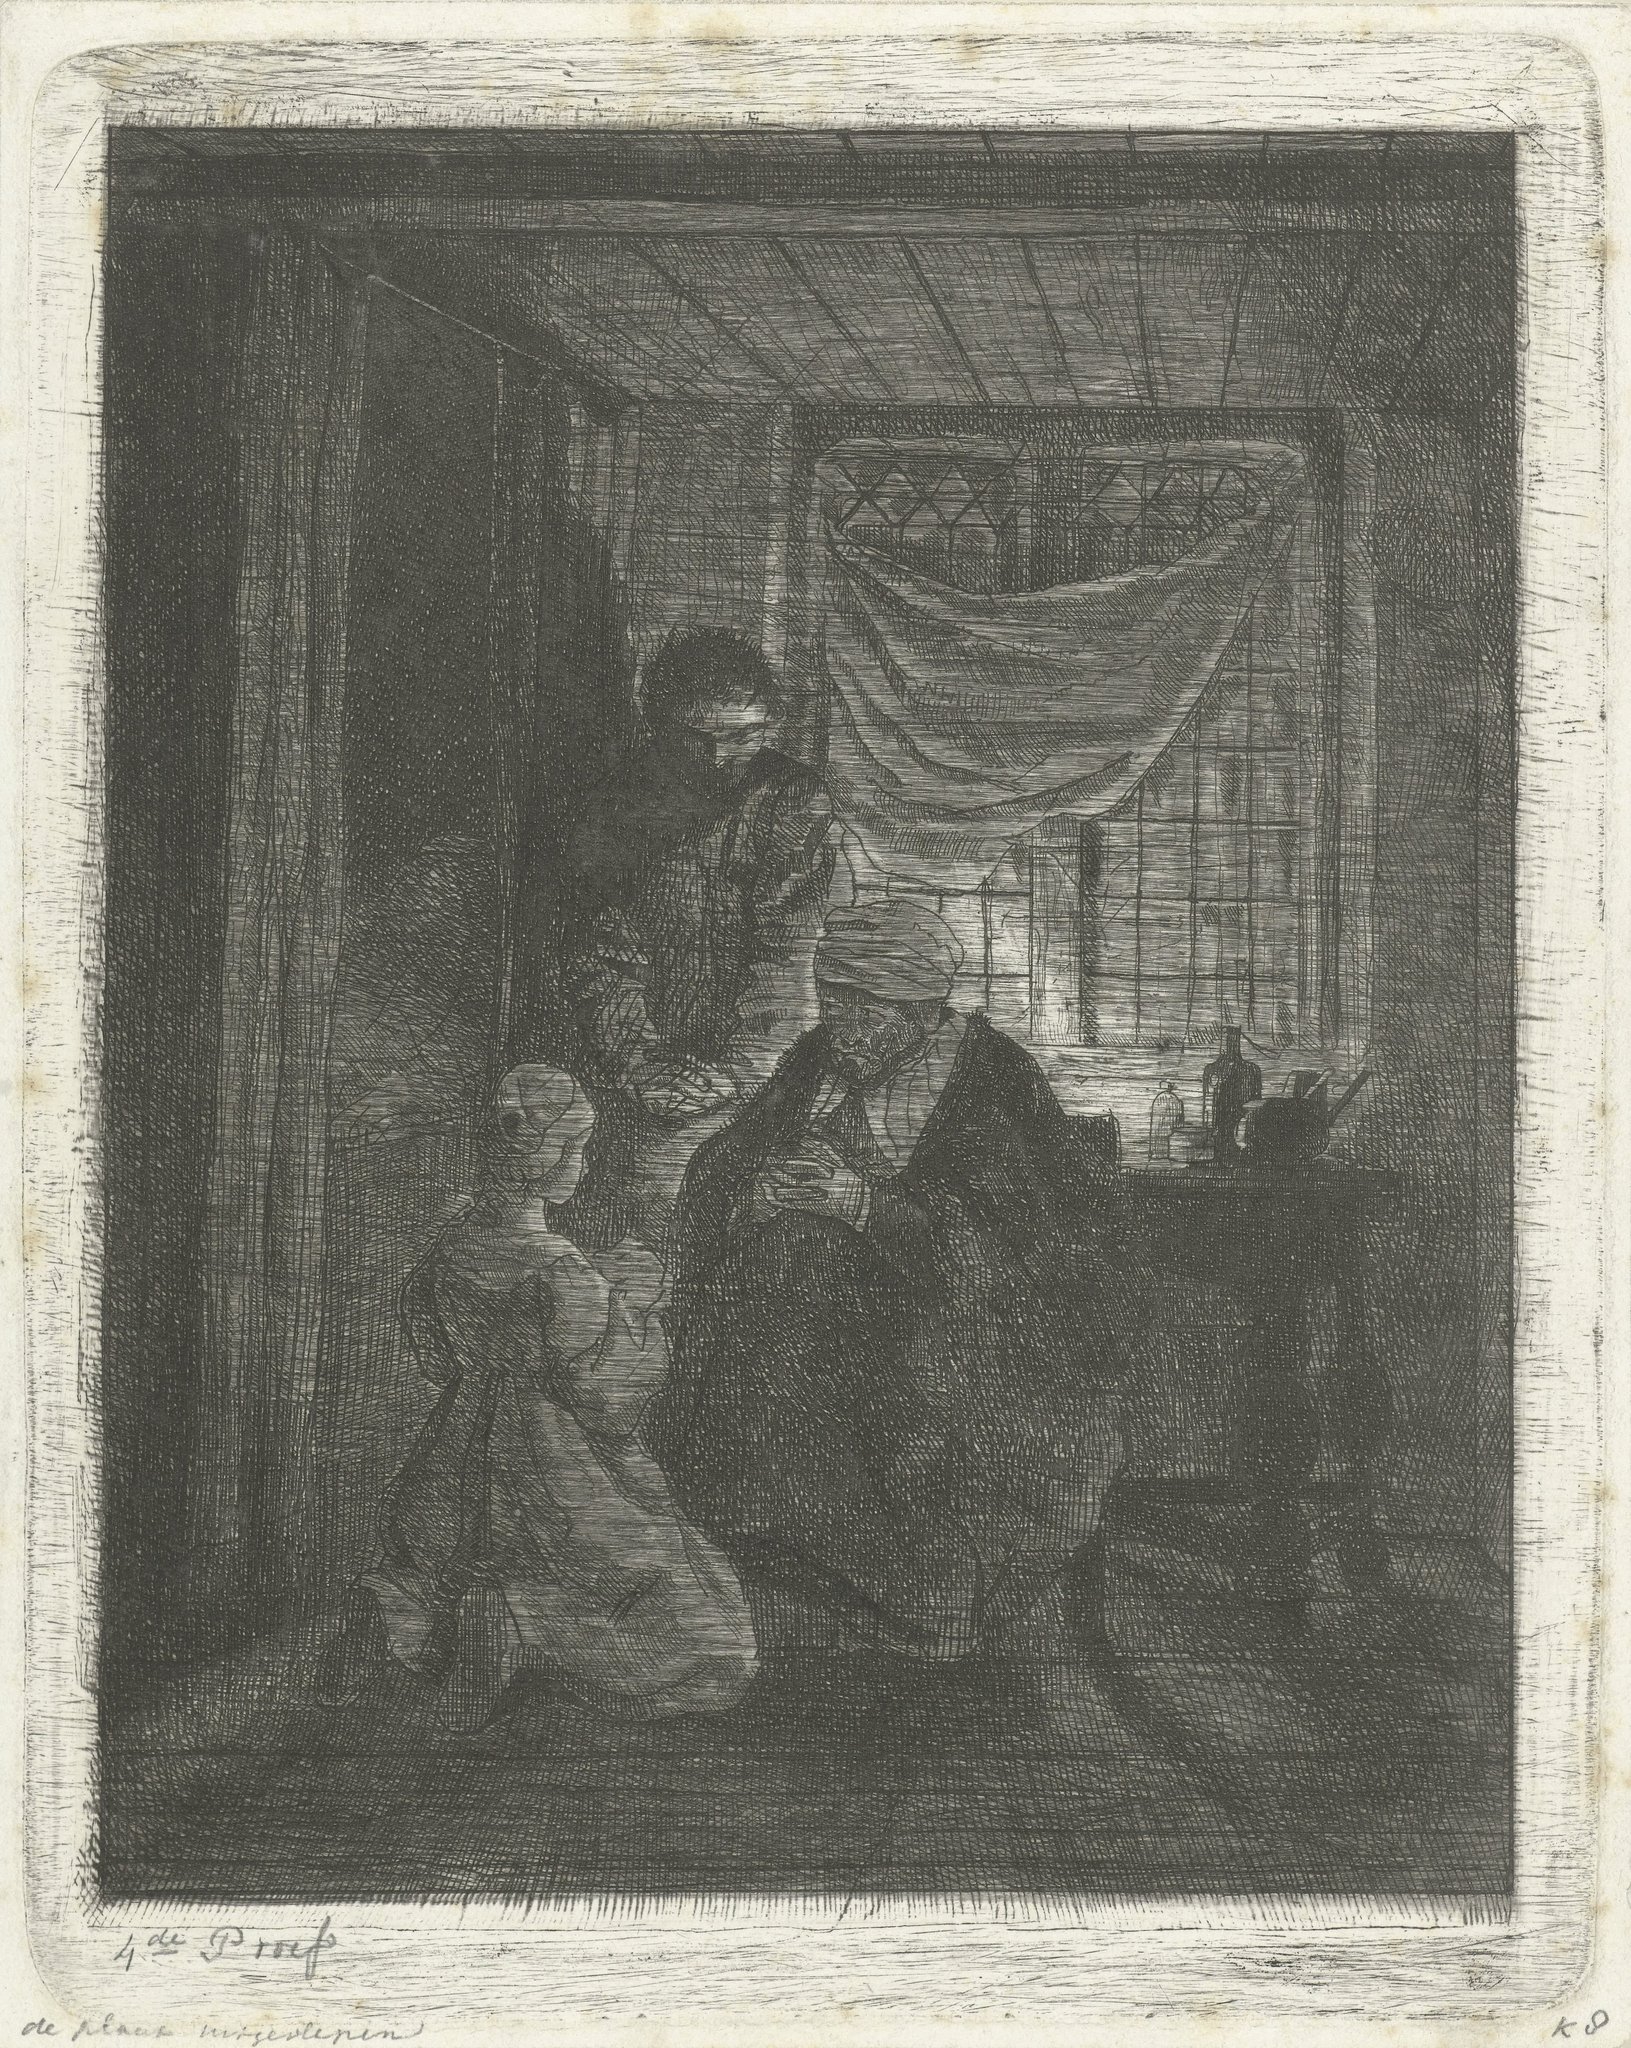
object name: print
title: Biddend gezin voor een bedstede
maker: jacobus ludovicus cornet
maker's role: draughtsman, print maker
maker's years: 1815-1882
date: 1825-1882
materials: paper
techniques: etching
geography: leiden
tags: (public) prayer, sick-bed, family group, especially parents with their child(ren)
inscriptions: collector's mark: Lugt 2228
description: Een woonkamer waar een man, een oude vrouw en een kind samen bidden voor een bedstede. In het bed ligt een zieke.